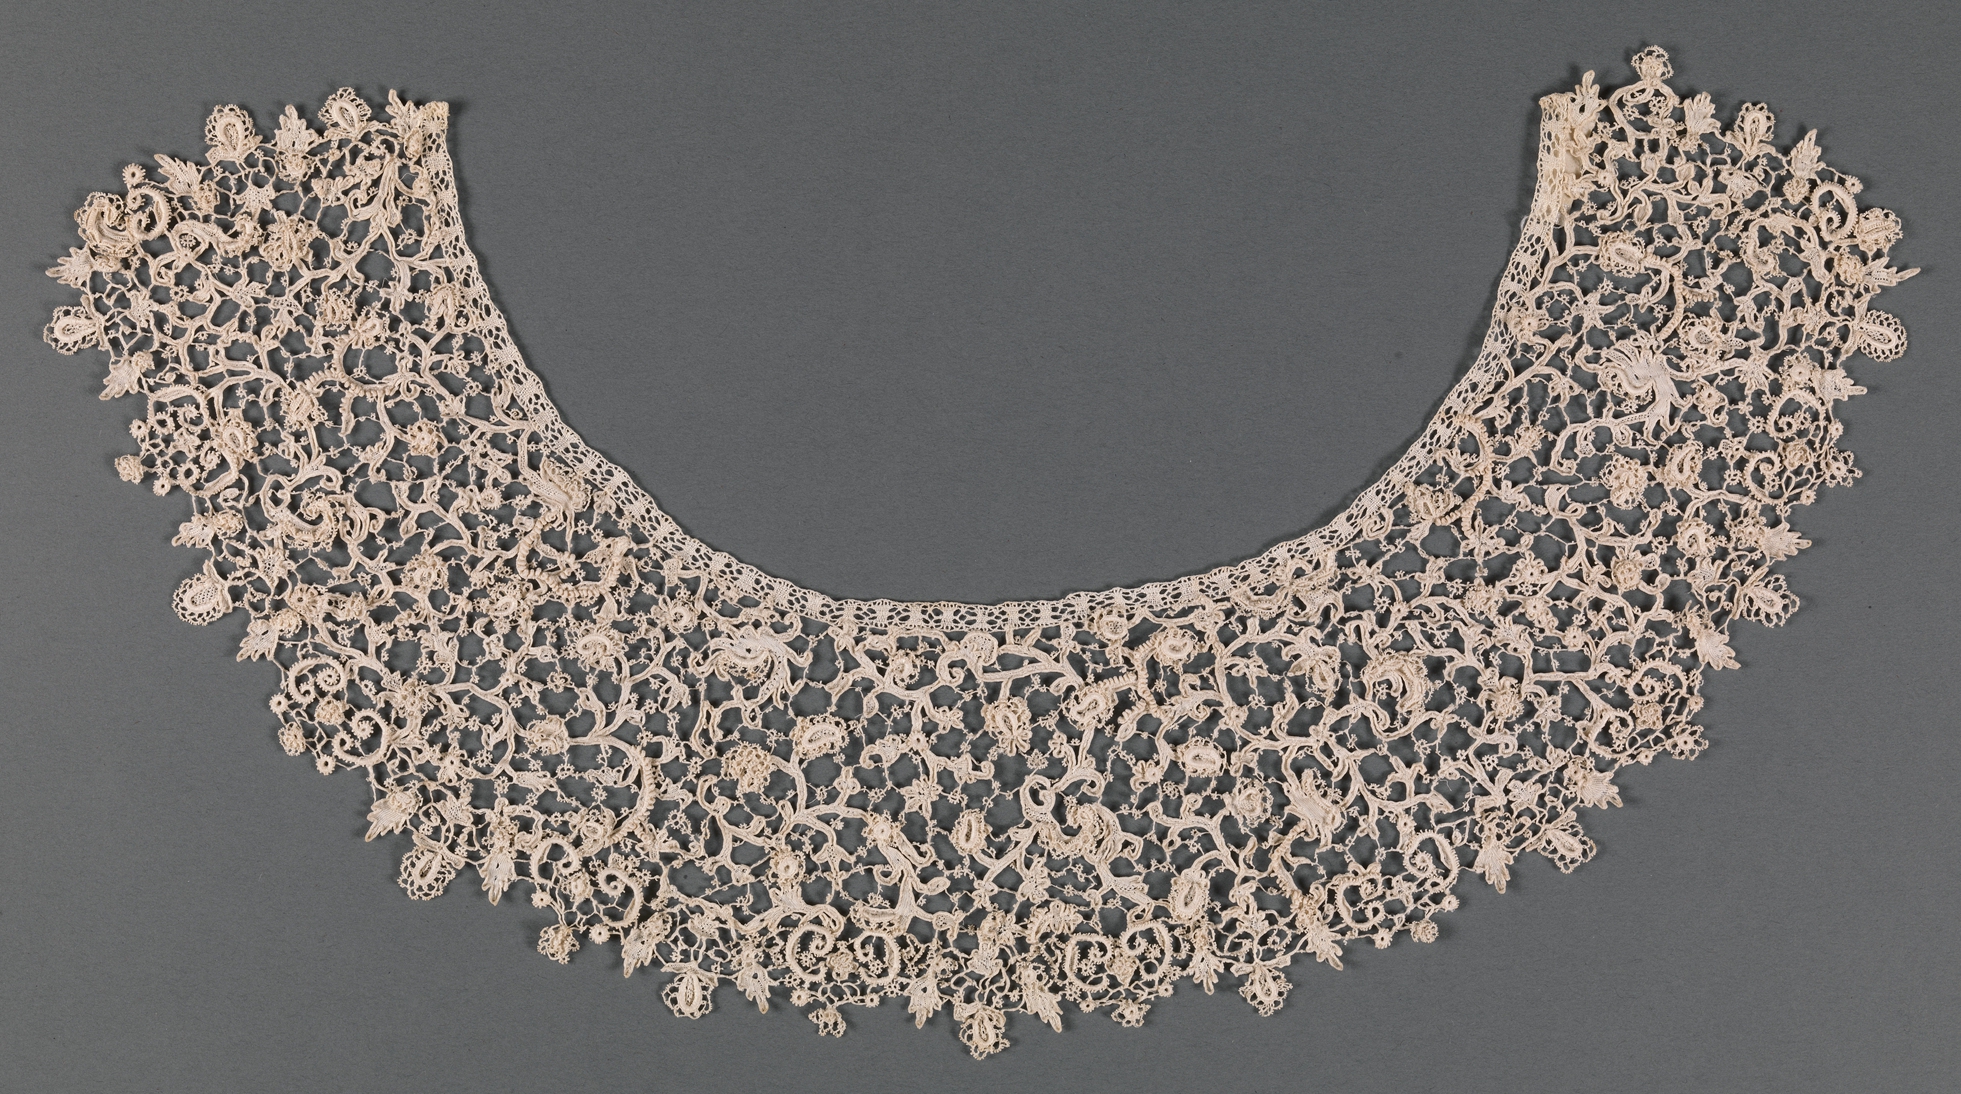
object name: collar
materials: linen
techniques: lace